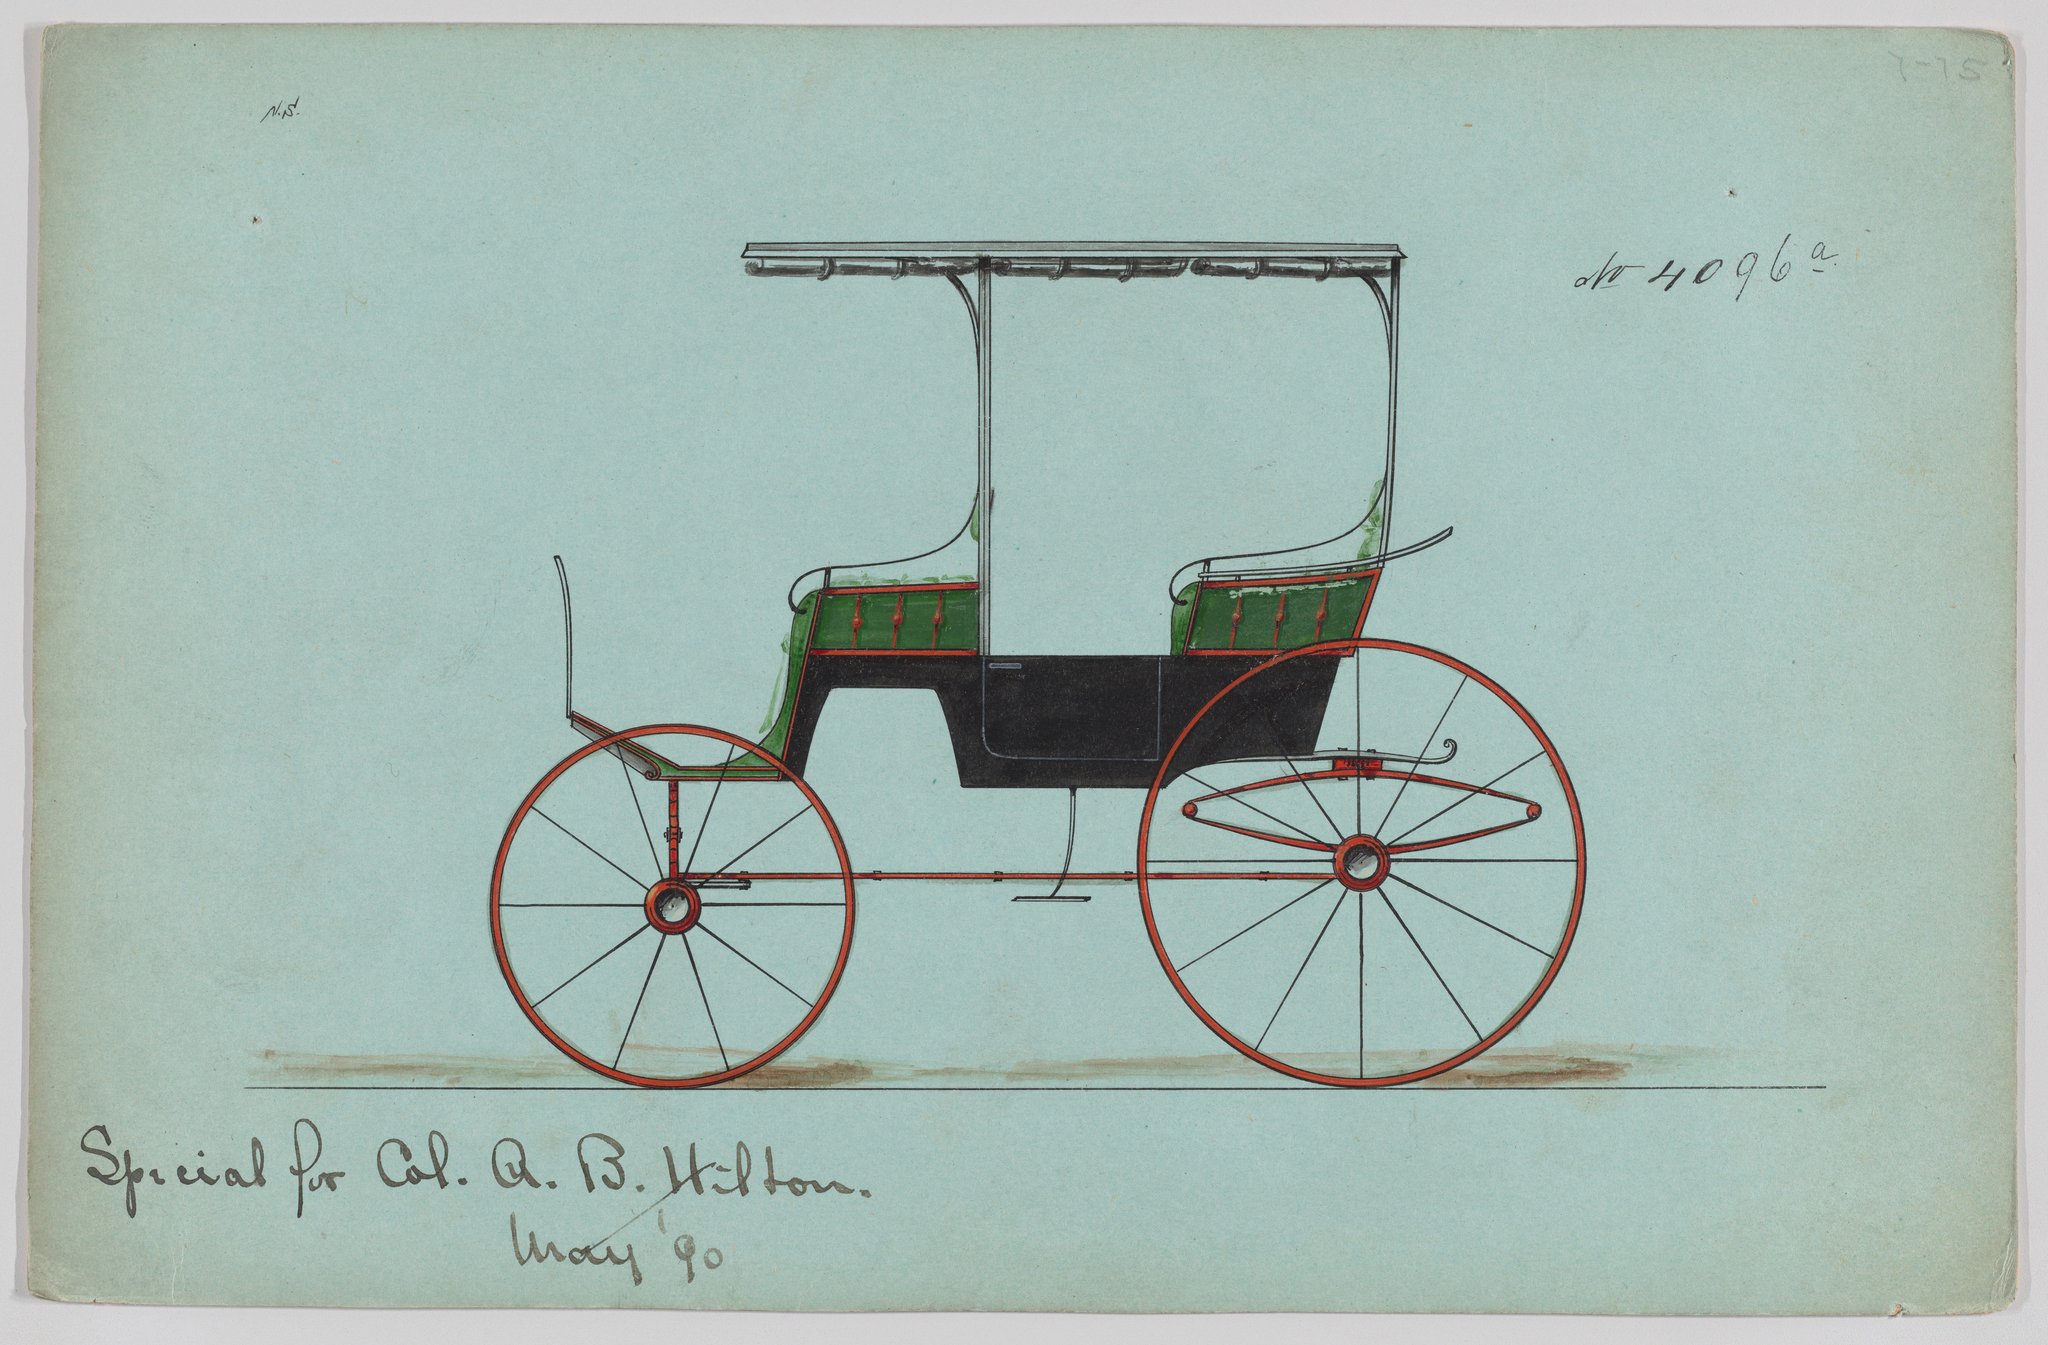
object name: drawing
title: Design for 2 seat Phaeton, no. 4096a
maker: brewster & co.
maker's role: manufacturer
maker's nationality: american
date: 1890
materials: gouache, gum arabic, ink, watercolor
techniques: pen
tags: carriages